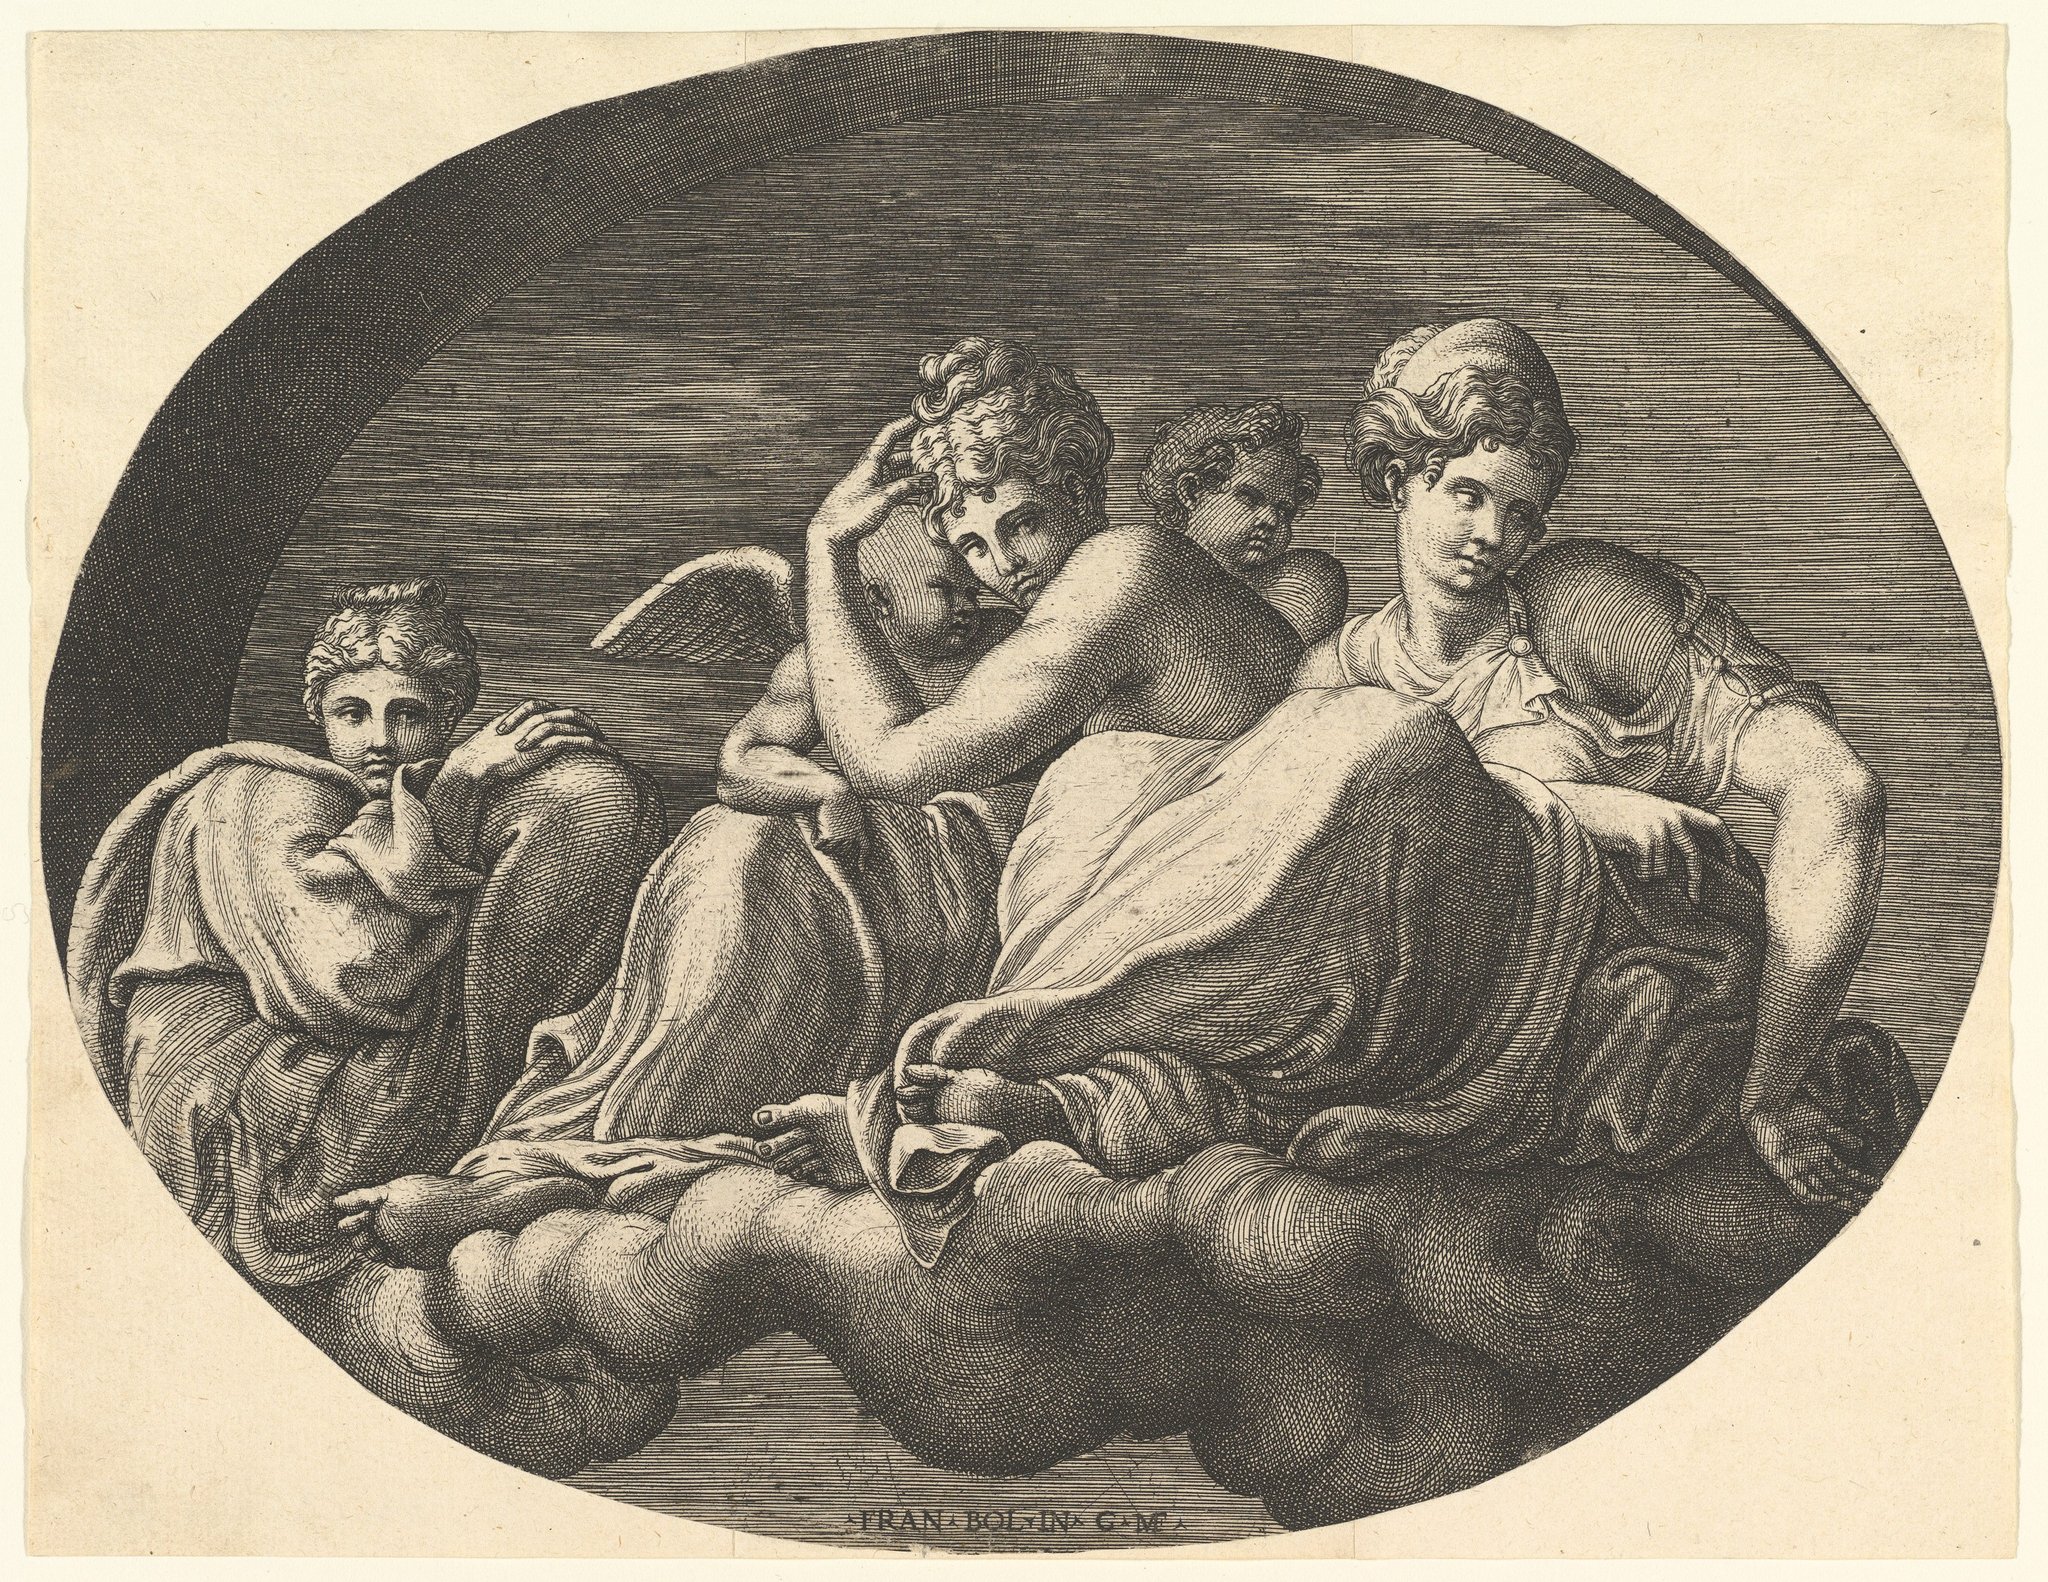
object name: print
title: Venus and Cupid, two other goddesses and a putto, from a series of eight compositions after Francesco Primaticcio's designs for the ceiling of the Ulysses Gallery (destroyed 1738–39) at Fontainebleau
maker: giorgio ghisi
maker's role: artist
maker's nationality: italian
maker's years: 1515-1582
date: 1560-1569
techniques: engraving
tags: cupid,putti,venus,goddess